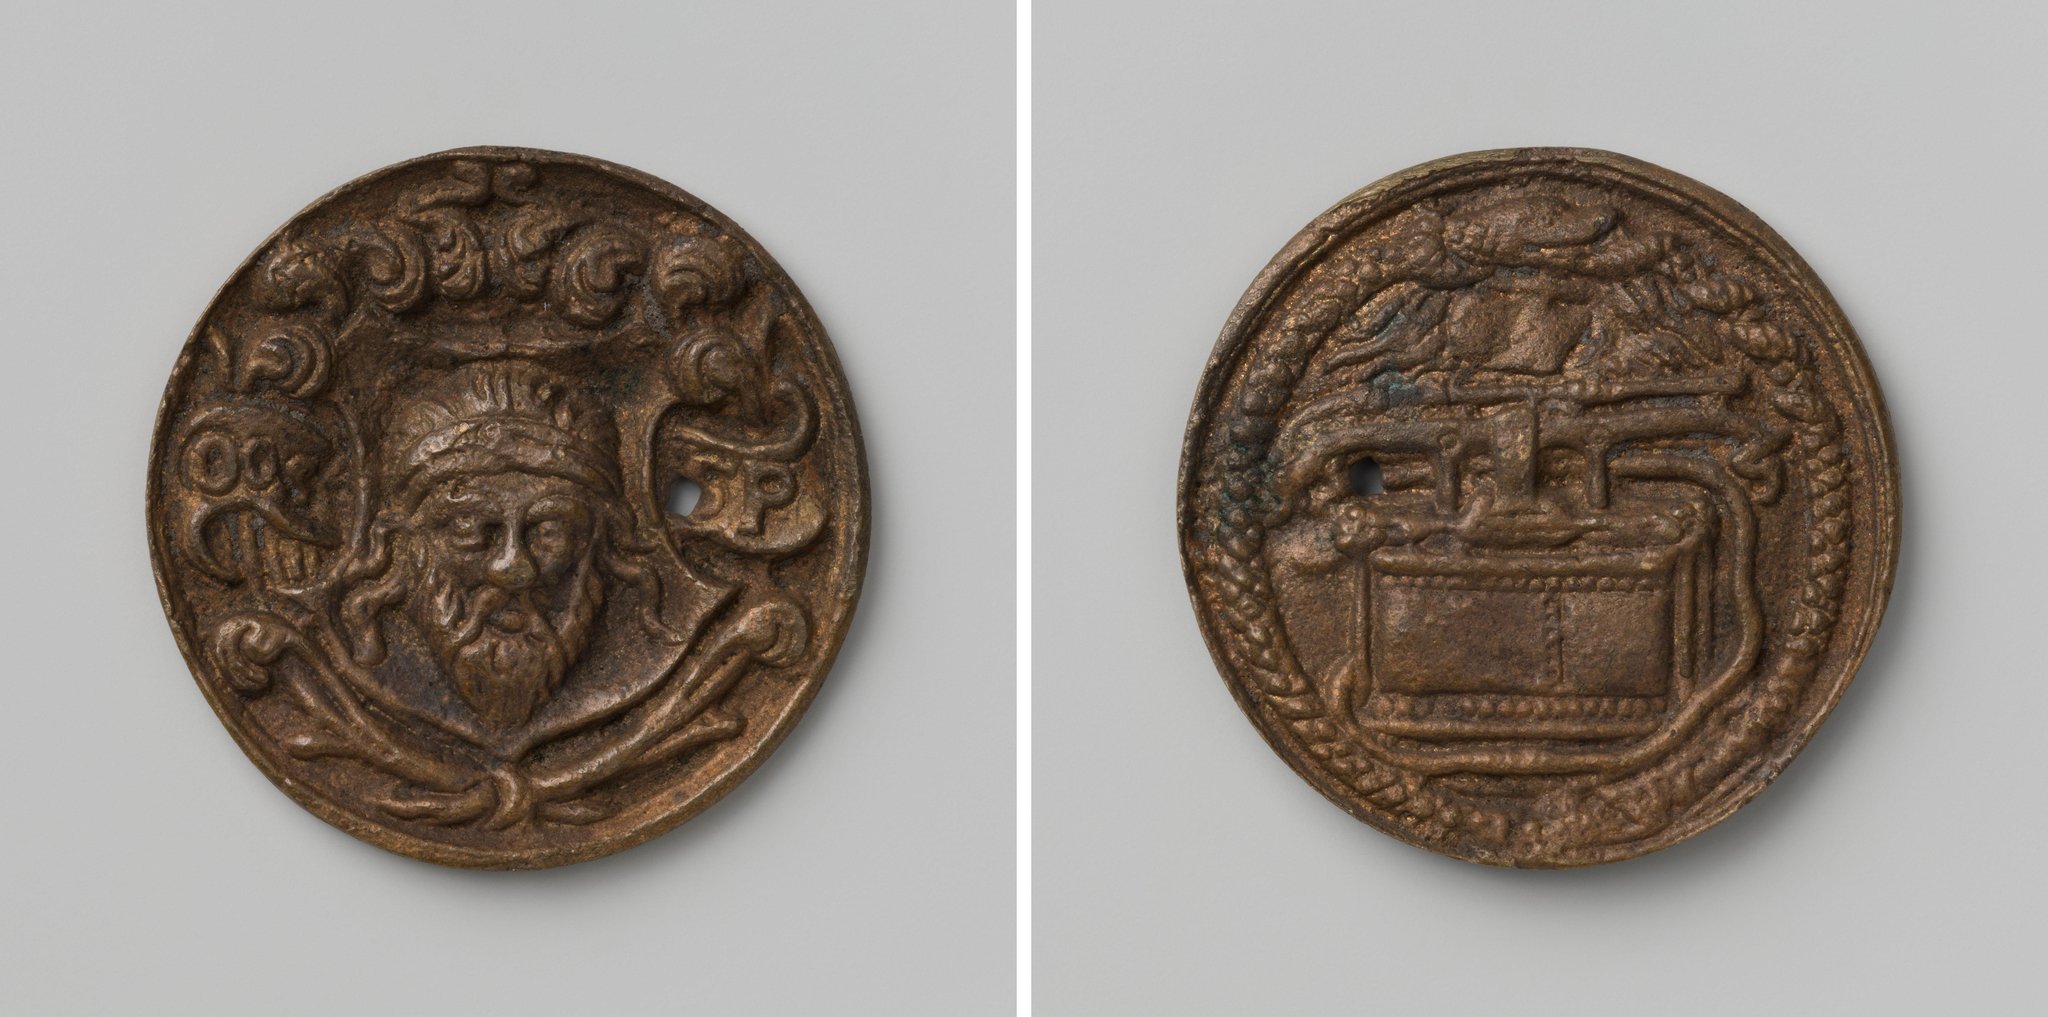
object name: medal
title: Wormer, brandspuitpenning van de Oosterspuit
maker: Anonymous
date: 1680-1800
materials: brass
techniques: casting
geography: wormer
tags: wormer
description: Messing penning met gat erin. Voorzijde: bebaard mannenhoofd in cartouche omgeven door versierd loofwerk; daarachter: lint met opschrift. Keerzijde: brandspuit onder leeg cartouche binnen slangerond